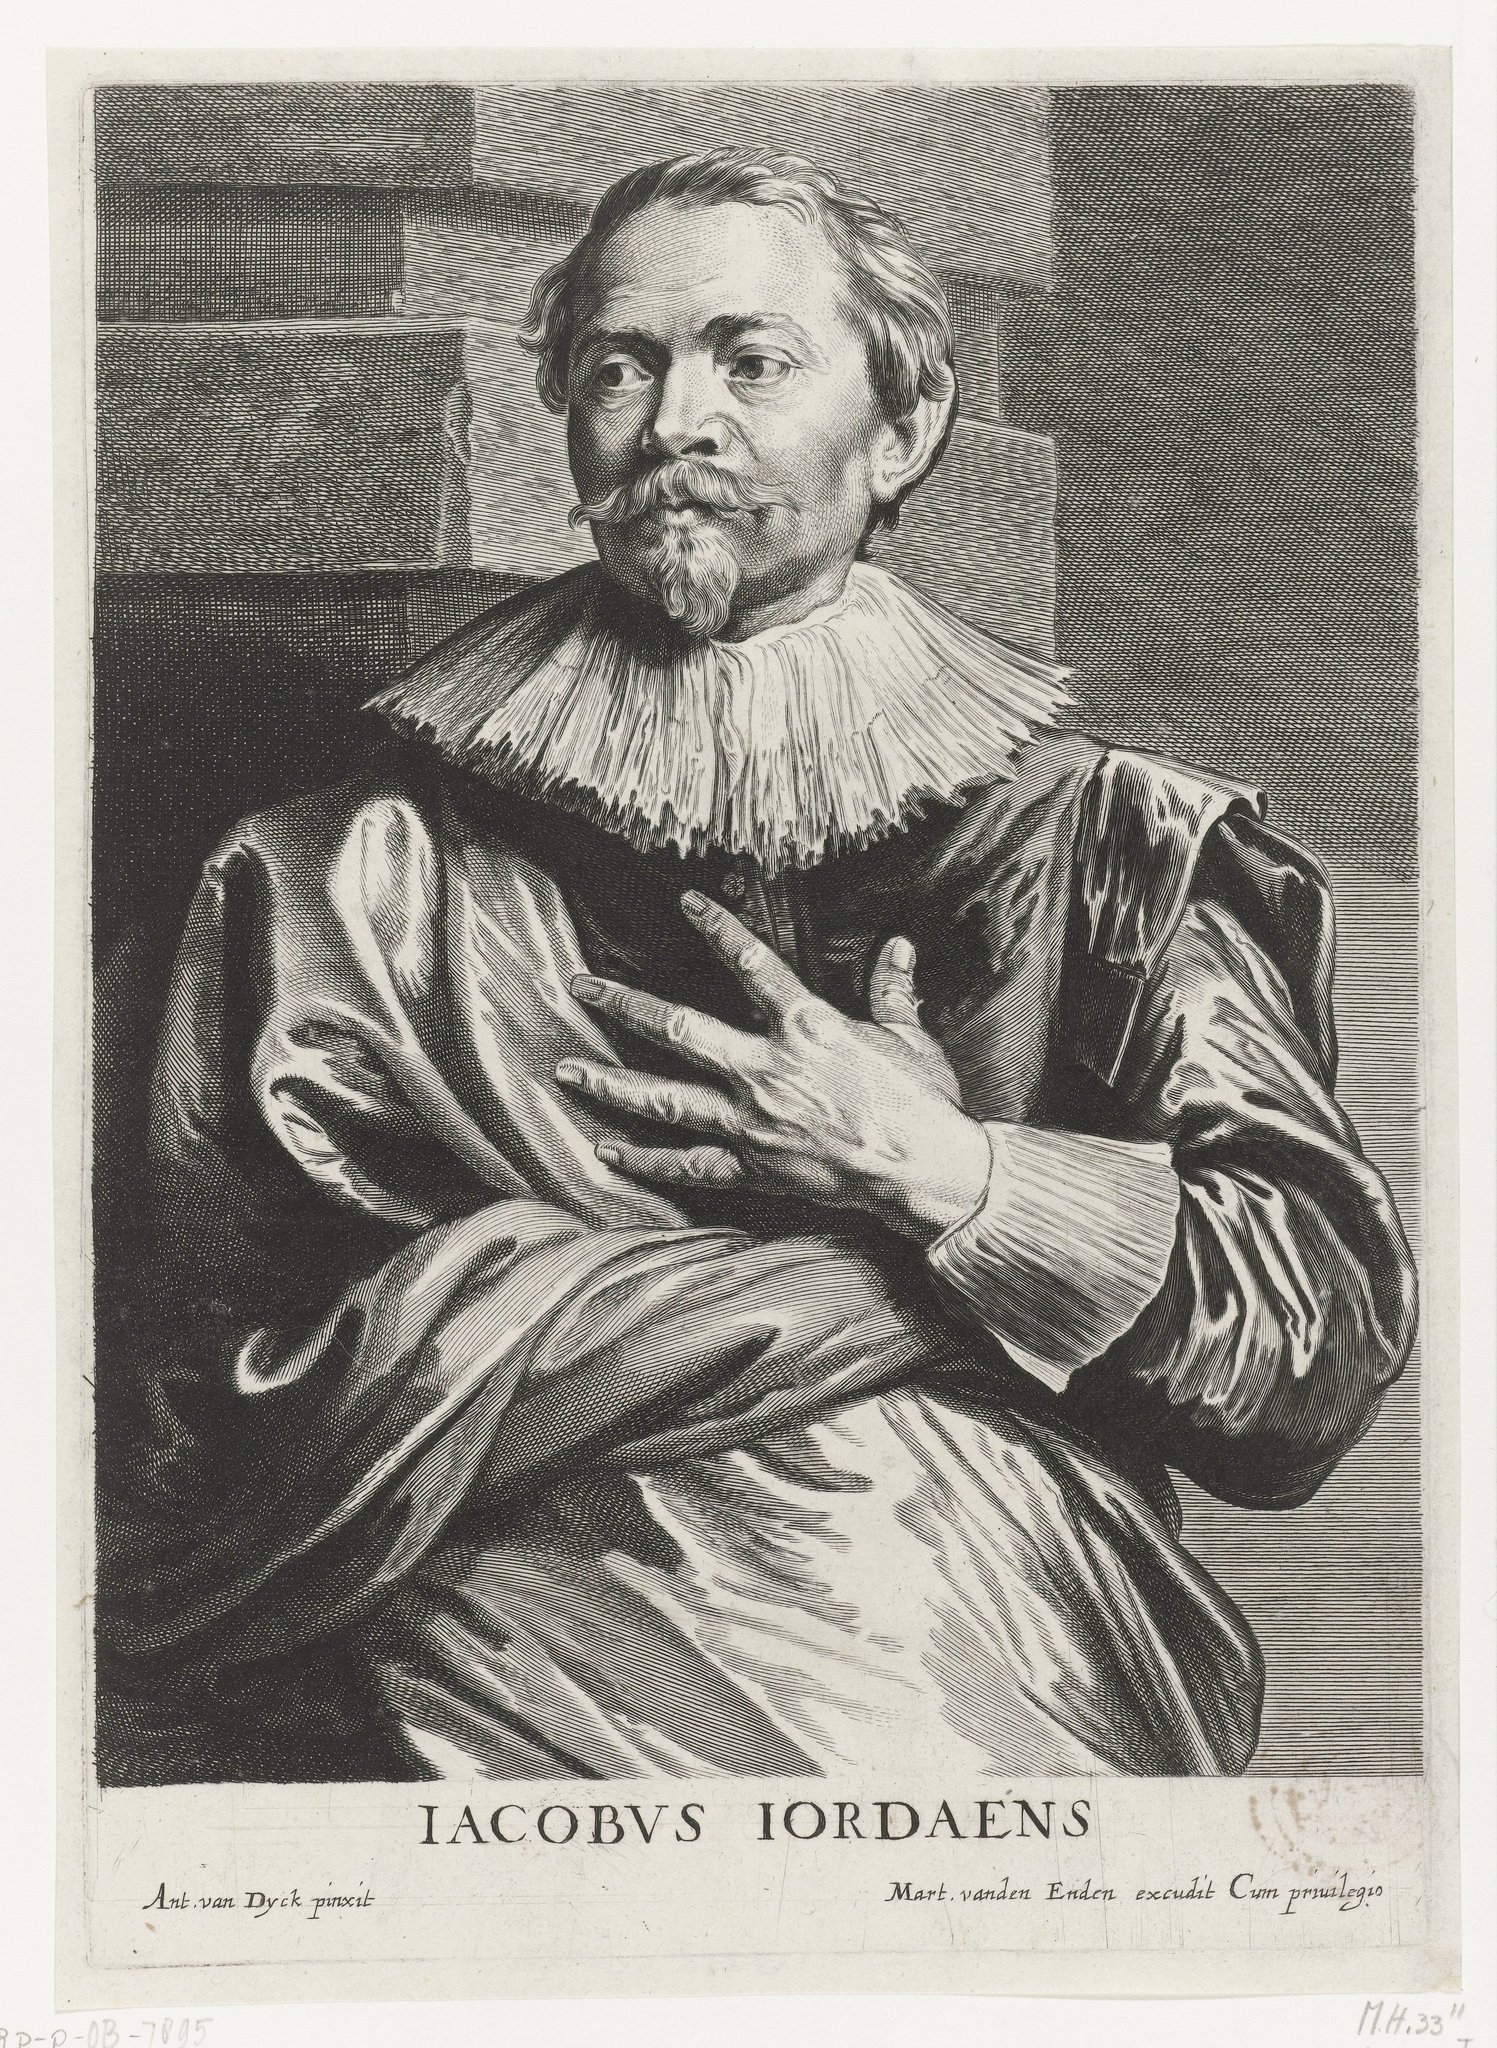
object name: print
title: Portret van Jacques Jordaens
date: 1628-1670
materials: paper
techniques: engraving, etching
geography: antwerp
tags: painter, designer, jacques jordaens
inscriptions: collector's mark: Lugt 240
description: Portret van de kunstenaar Jacques Jordaens. Hij houdt zijn linkerhand tegen zijn borst. In de marge de naam van de geportretteerde.